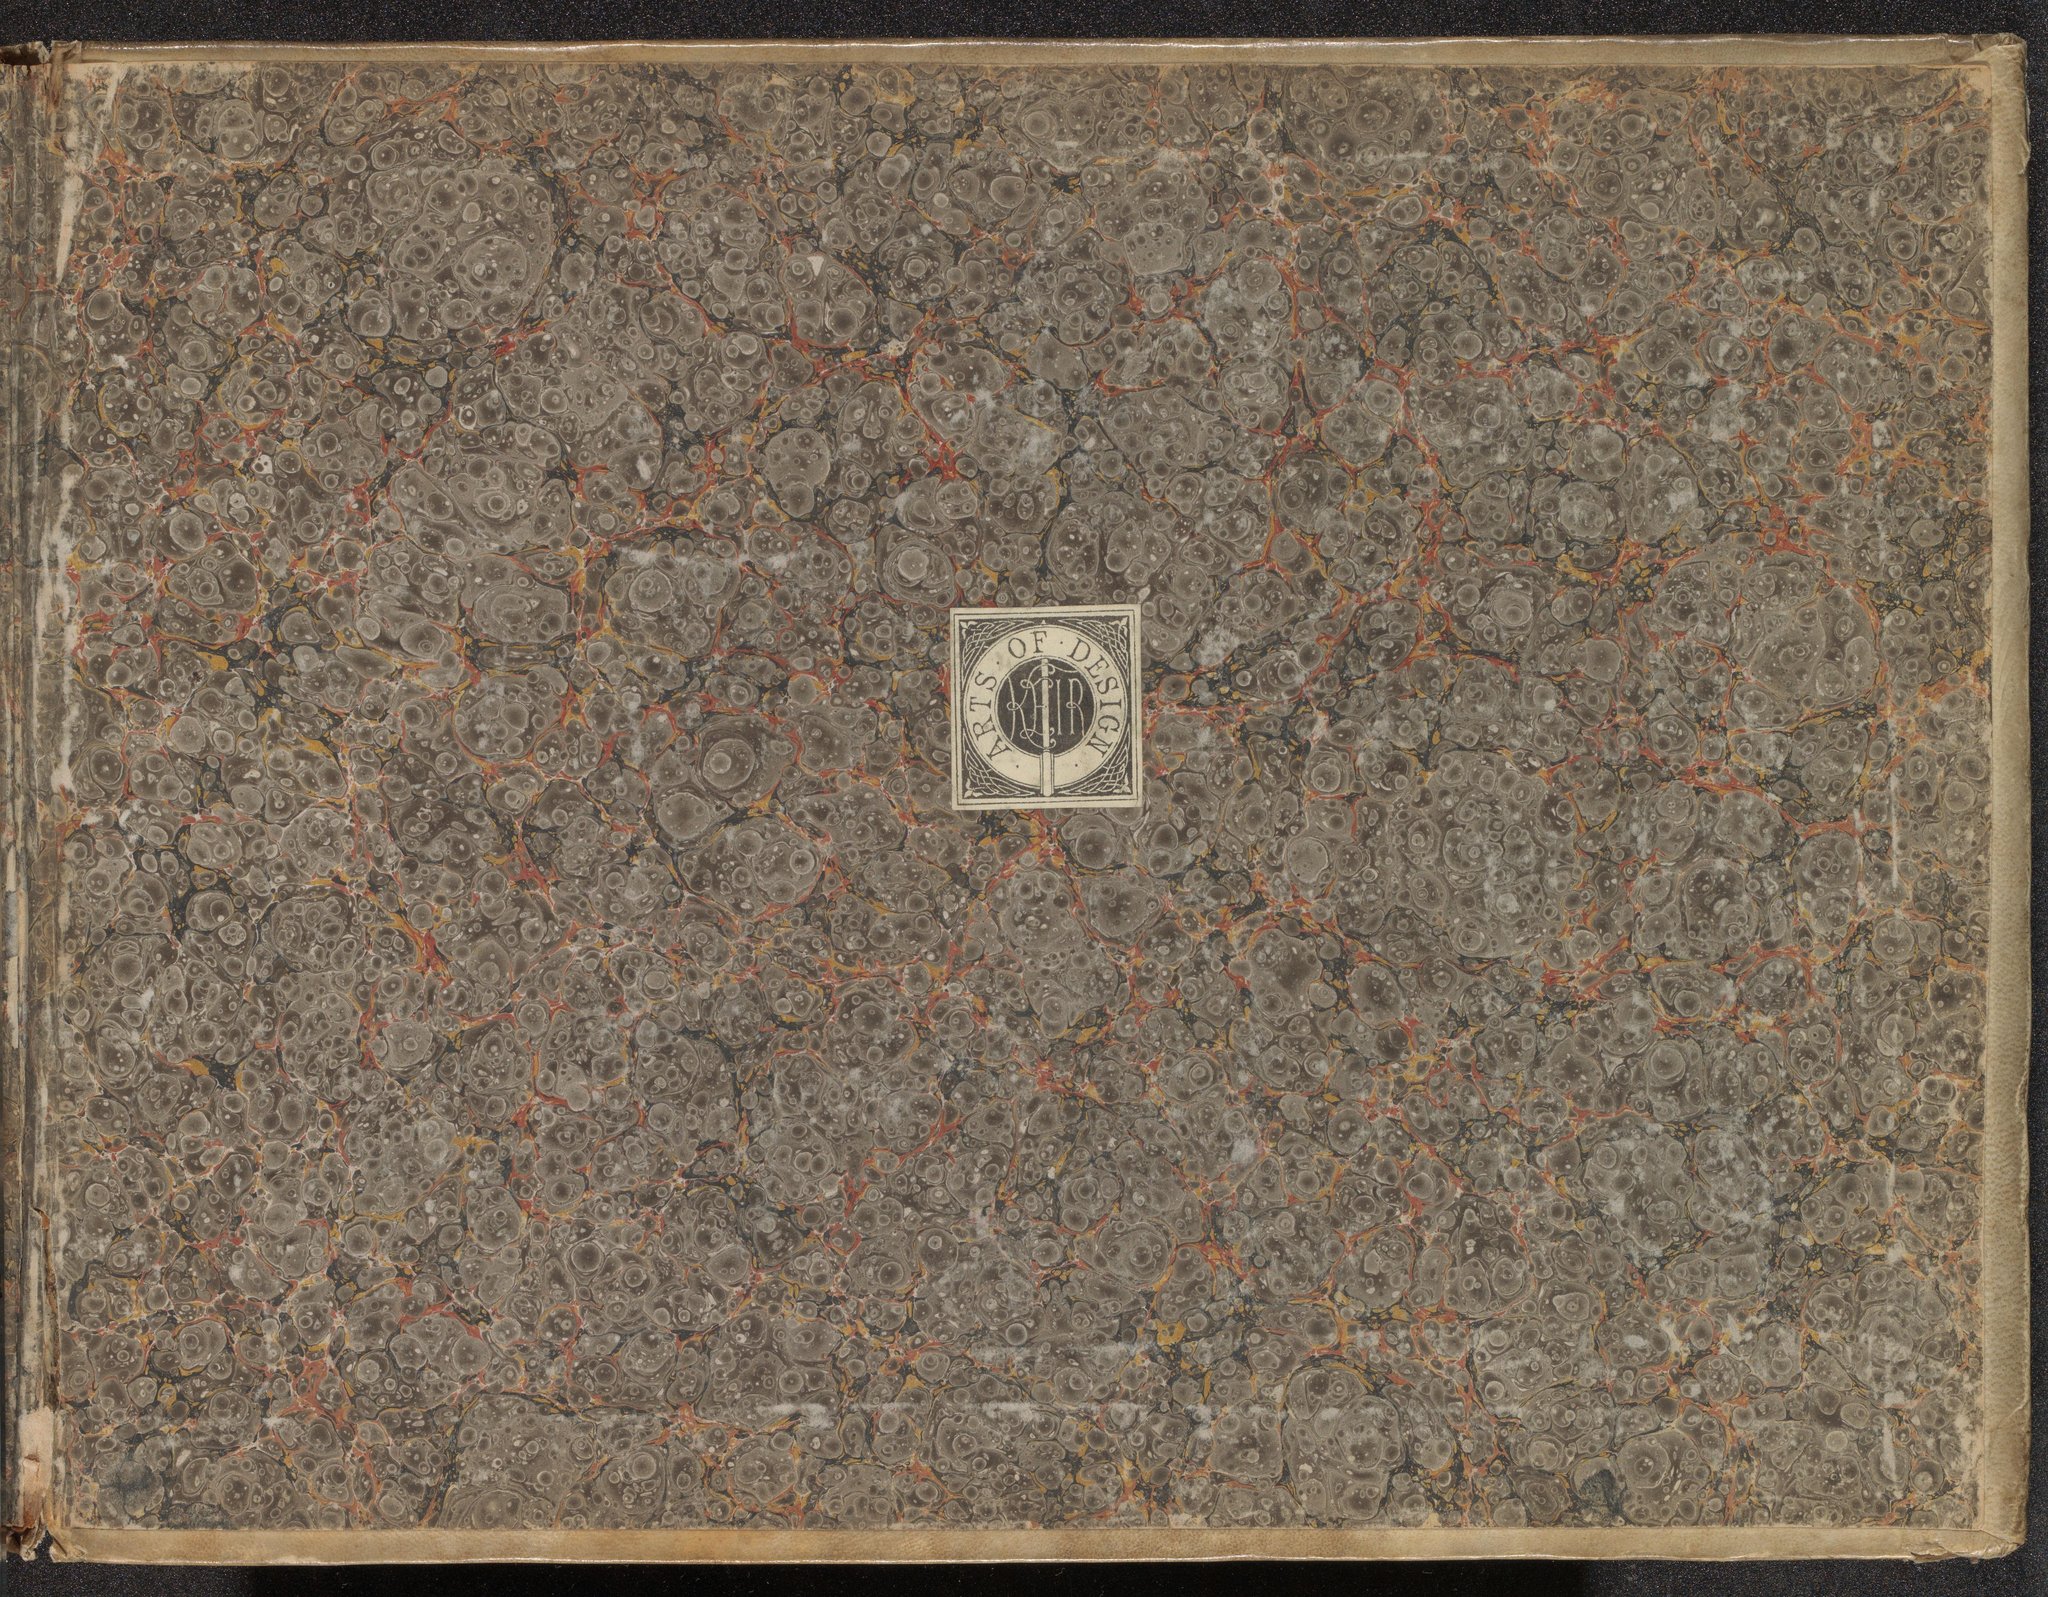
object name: bookplate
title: Ex libris van Sir William Stirling Maxwell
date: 1838-1878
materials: paper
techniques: woodcut, marbling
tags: venice, politician, william stirling maxwell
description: Ex libris van boekverzamelaar Sir William Stirling Maxwell met de tekst: Keir, Arts of Design. Waarschijnlijk refererend aan dat deel van zijn collectie dat hij verzamelde onder de noemer Arts of Design. Ex libris geplakt op achterste dekblad. Deze prent maakt deel uit van een album.